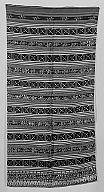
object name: skirt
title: Woman's Ceremonial Skirt (Tapis)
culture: lampung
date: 1801-1900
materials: cotton, gold, lead, thread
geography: indonesia